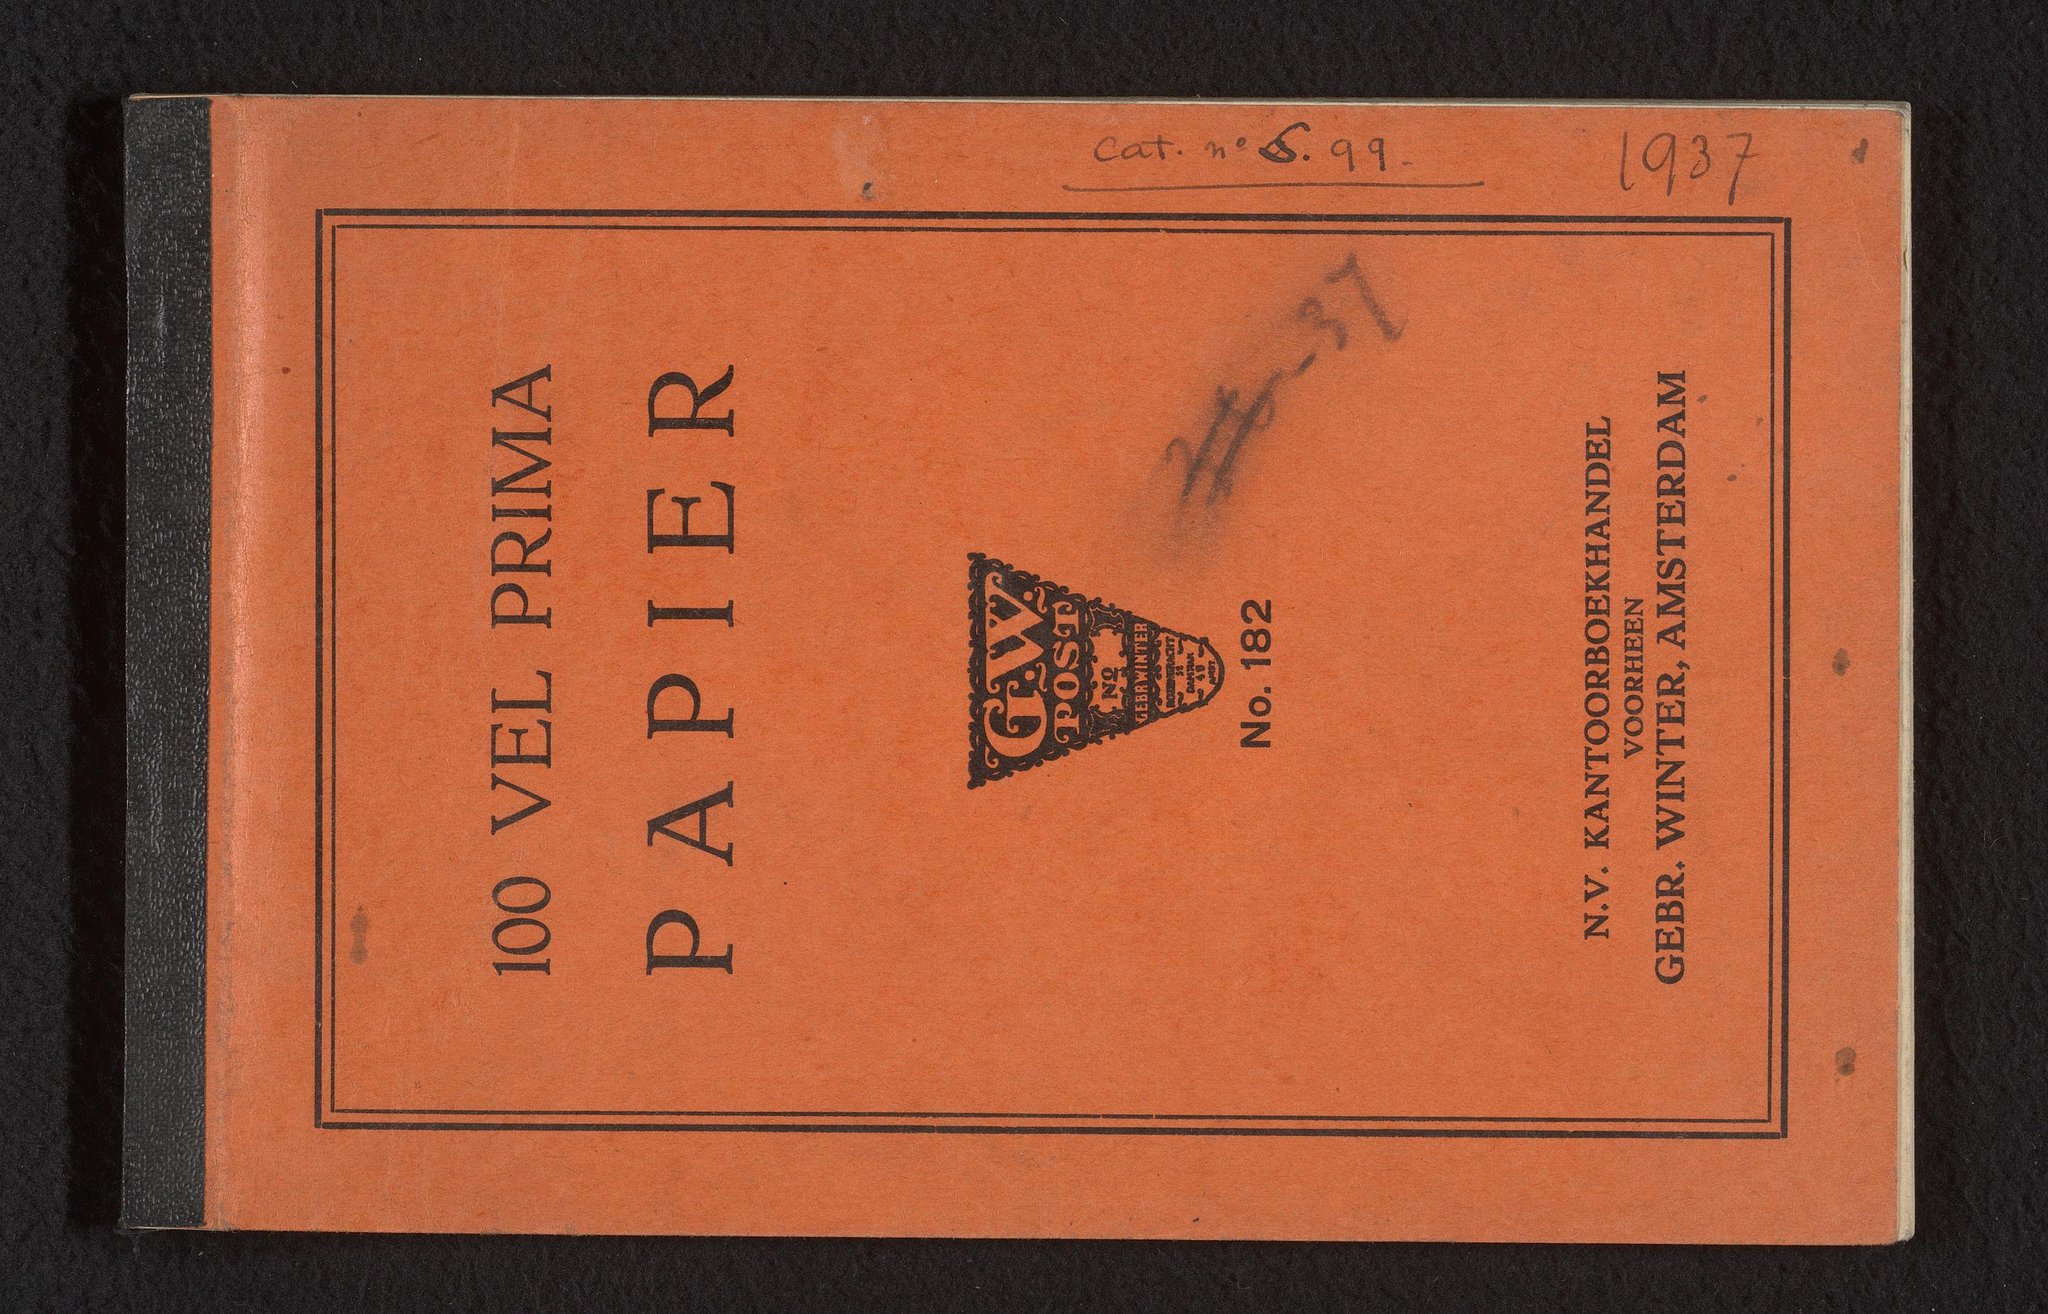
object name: sketchbook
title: Schetsboek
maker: leo gestel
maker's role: draughtsman, print maker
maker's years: 1881-1941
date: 1937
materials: paper, pencil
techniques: drawing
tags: farm (building)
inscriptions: workshop stamp: Lugt 1078a, inscription: ‘schetsboek 1937./ 7 bladen eenzijdig beteekend’, date: ‘1937’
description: Schetsboek met zeven schetsen van een landschap met boederij.